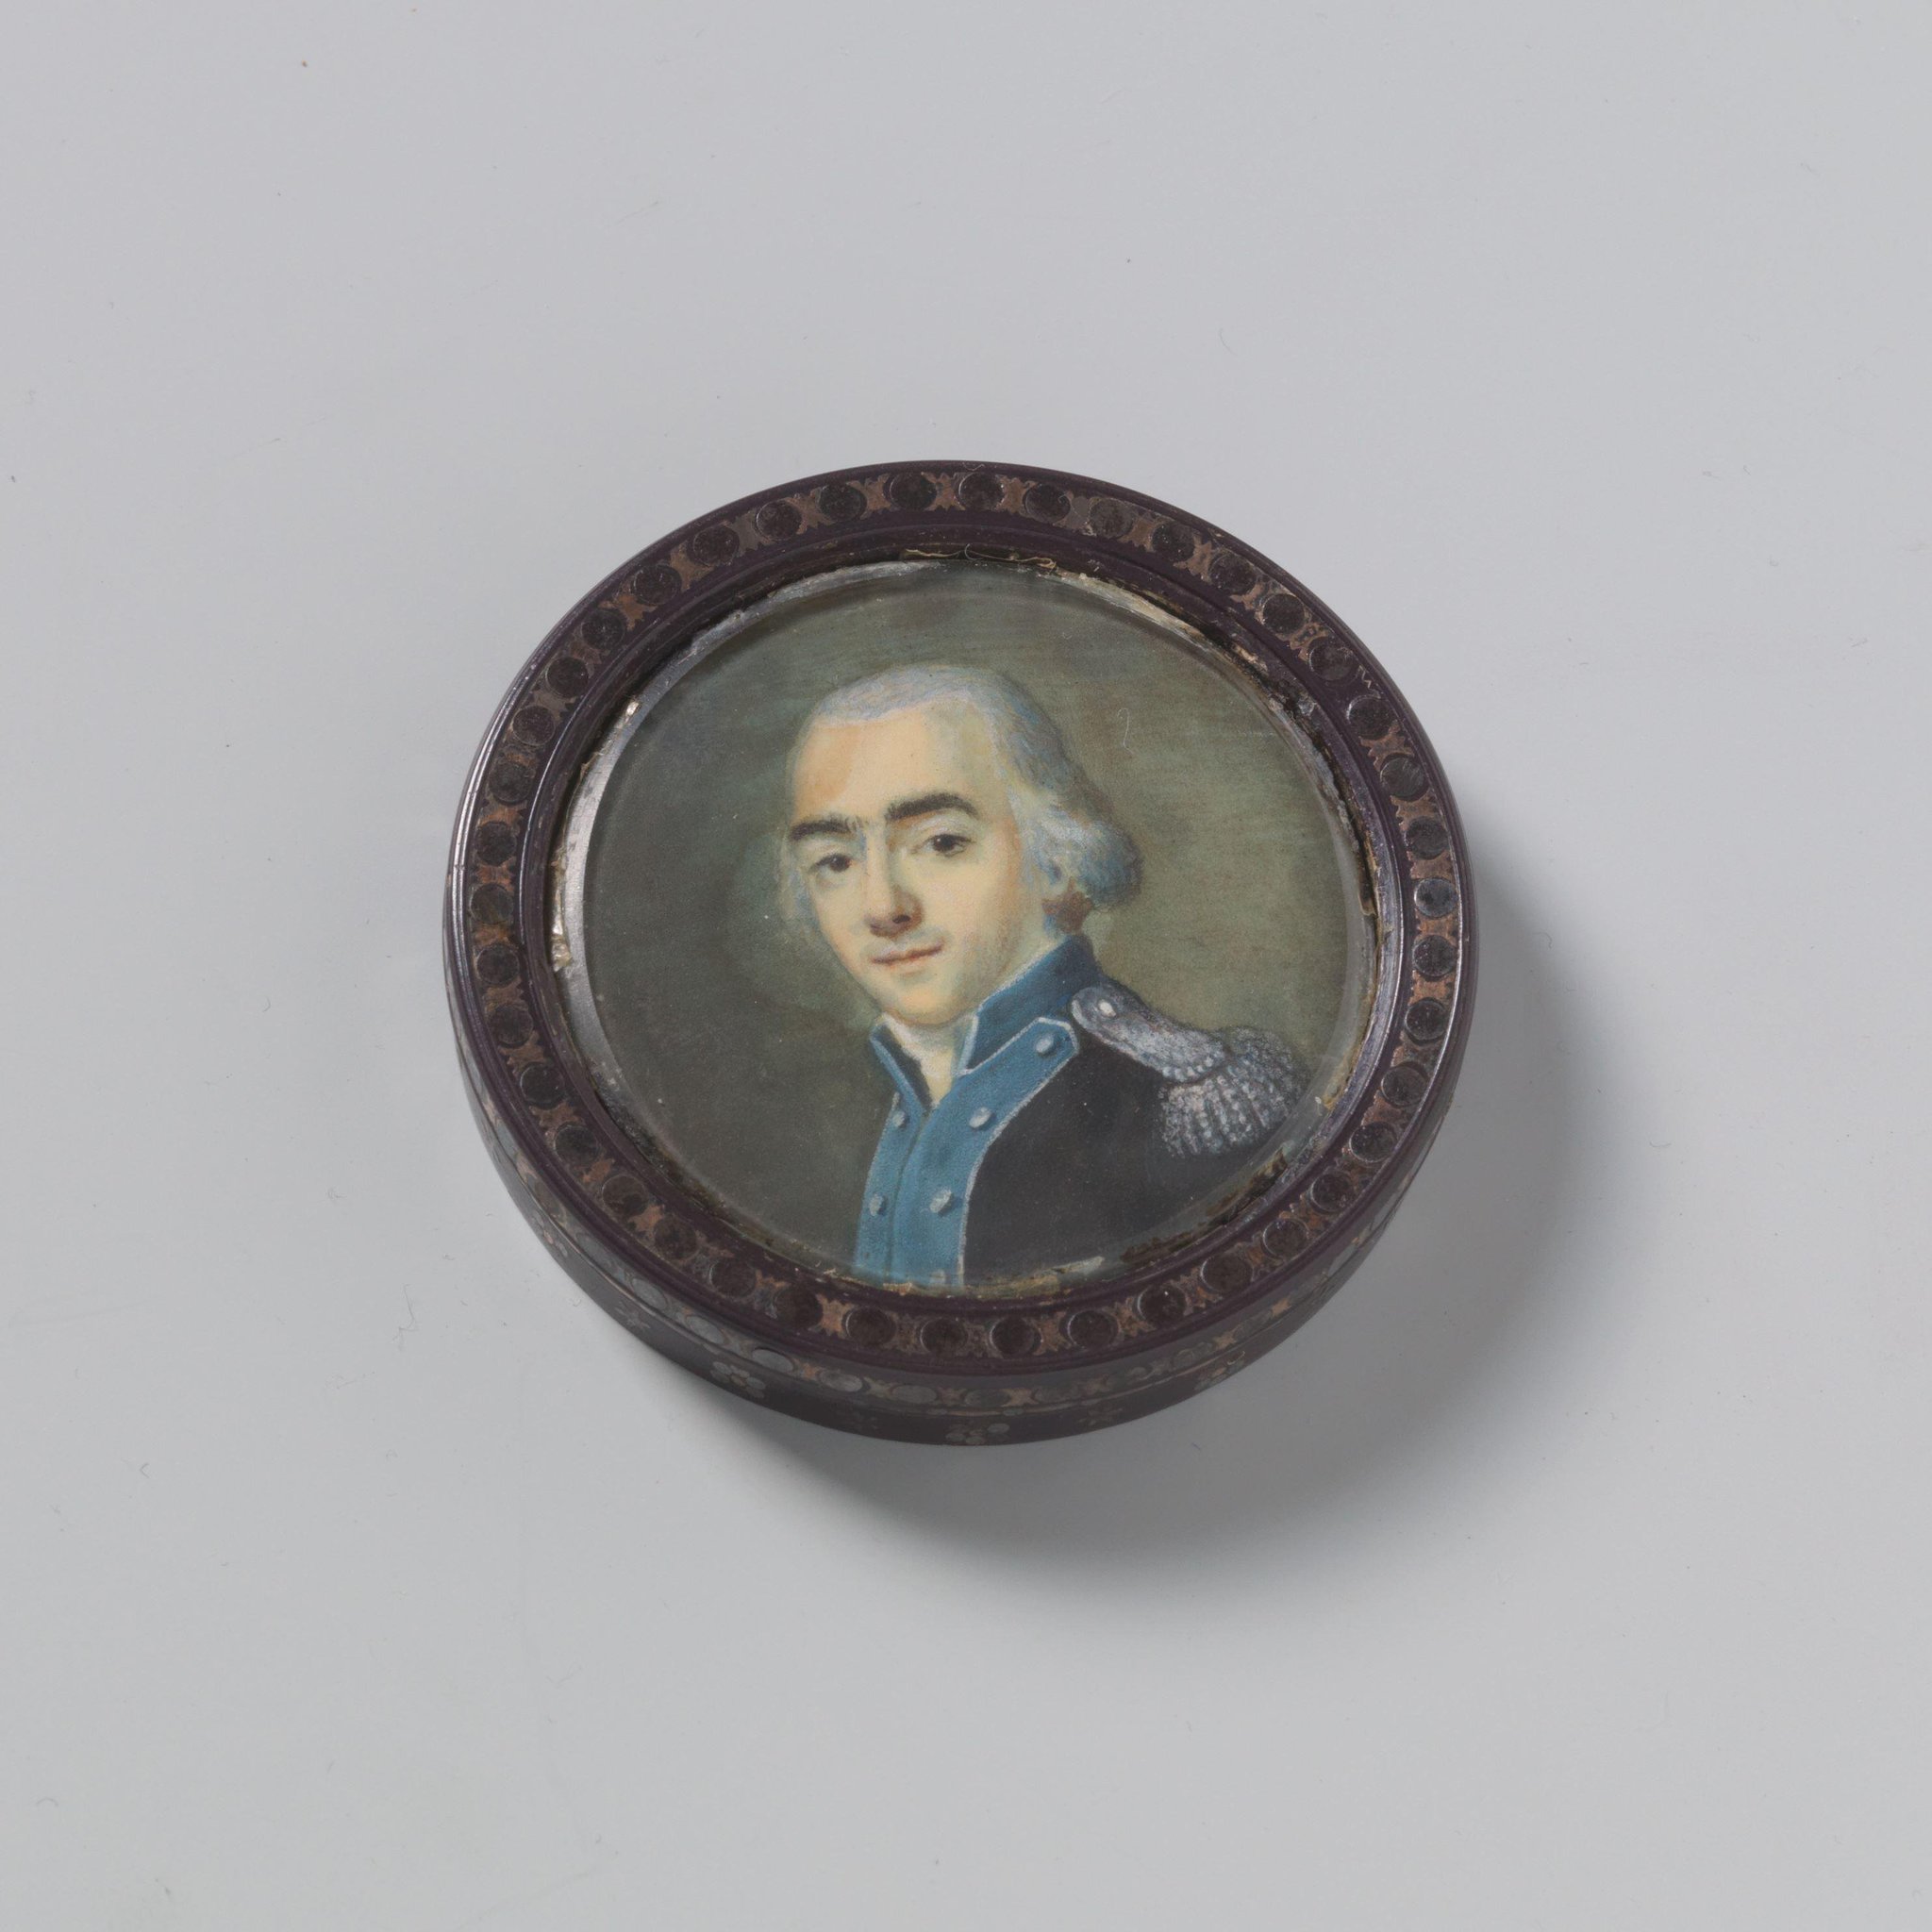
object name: box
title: Deksel van een lakwerkdoos met het portret van Herman Willem Daendels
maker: Anonymous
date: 1762-1818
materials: brass, glass, metal, paper, silver, watercolor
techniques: lacquer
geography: netherlands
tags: herman willem daendels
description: Rond lakwerkdoosje ingelegd met messing en zilver (blank metaal). Op het deksel een portret van Herman Willem Daendels in zwart en blauw uniform. Borststuk, het hoofd naar links gewend.